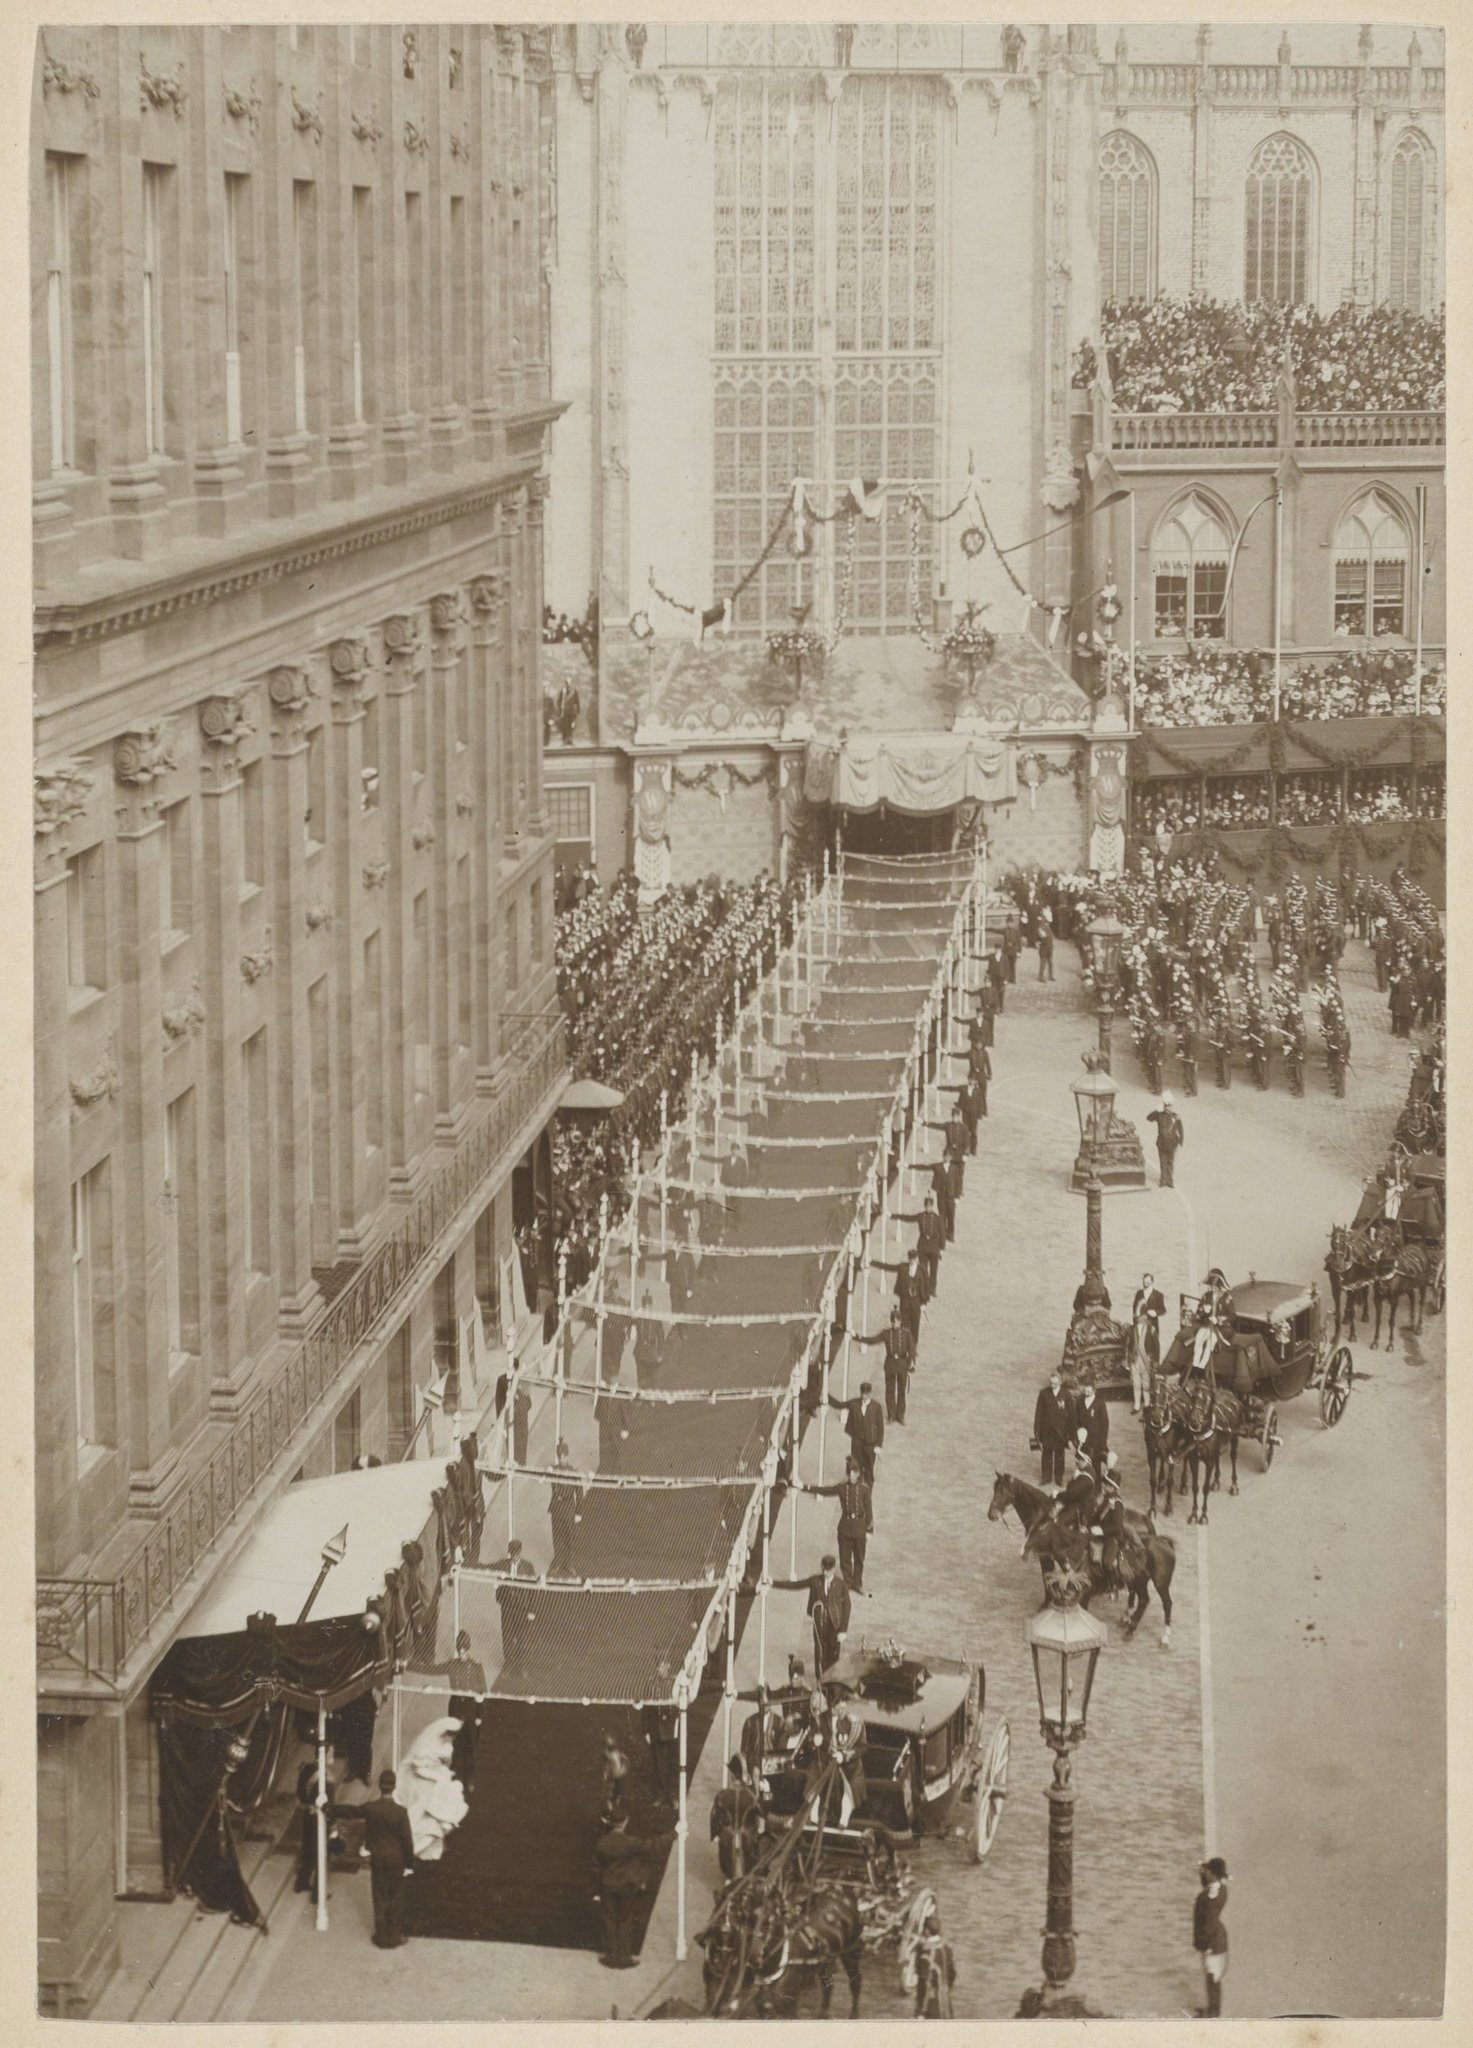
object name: photograph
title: Baldakijn op de Dam te Amsterdam bij de inhuldiging van Koningin Wilhelmina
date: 1898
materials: cardboard, paper, photographic support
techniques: collodion silver print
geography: dam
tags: the hague, print maker, wilhelmina of the netherlands, ceremonial celebration of installation of a ruler, public festivities on the occasion of royal events, canopy, baldachin, installation of a ruler - bb - female ruler, four-wheeled, animal-drawn vehicle, e.g.: cab, carriage, coach, palace, church (exterior), guard of honour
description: Tussen het Koninklijk Paleis en de Nieuwe Kerk is een baldakijn aangebracht. Aan weerszijden daarvan 32 cadetten van de Koninklijke Militaire Academie en adelborsten van de Koninklijke Nederlandse Marine. Rechts hofrijtuigen voor het vervoer van genodigden. Onduidelijk is wie links op de foto het paleis verlaat. Onderdeel van Fotoalbum met 11 opnames van de inhuldiging van Koningin Wilhelmina en de inhuldigingsfeesten.